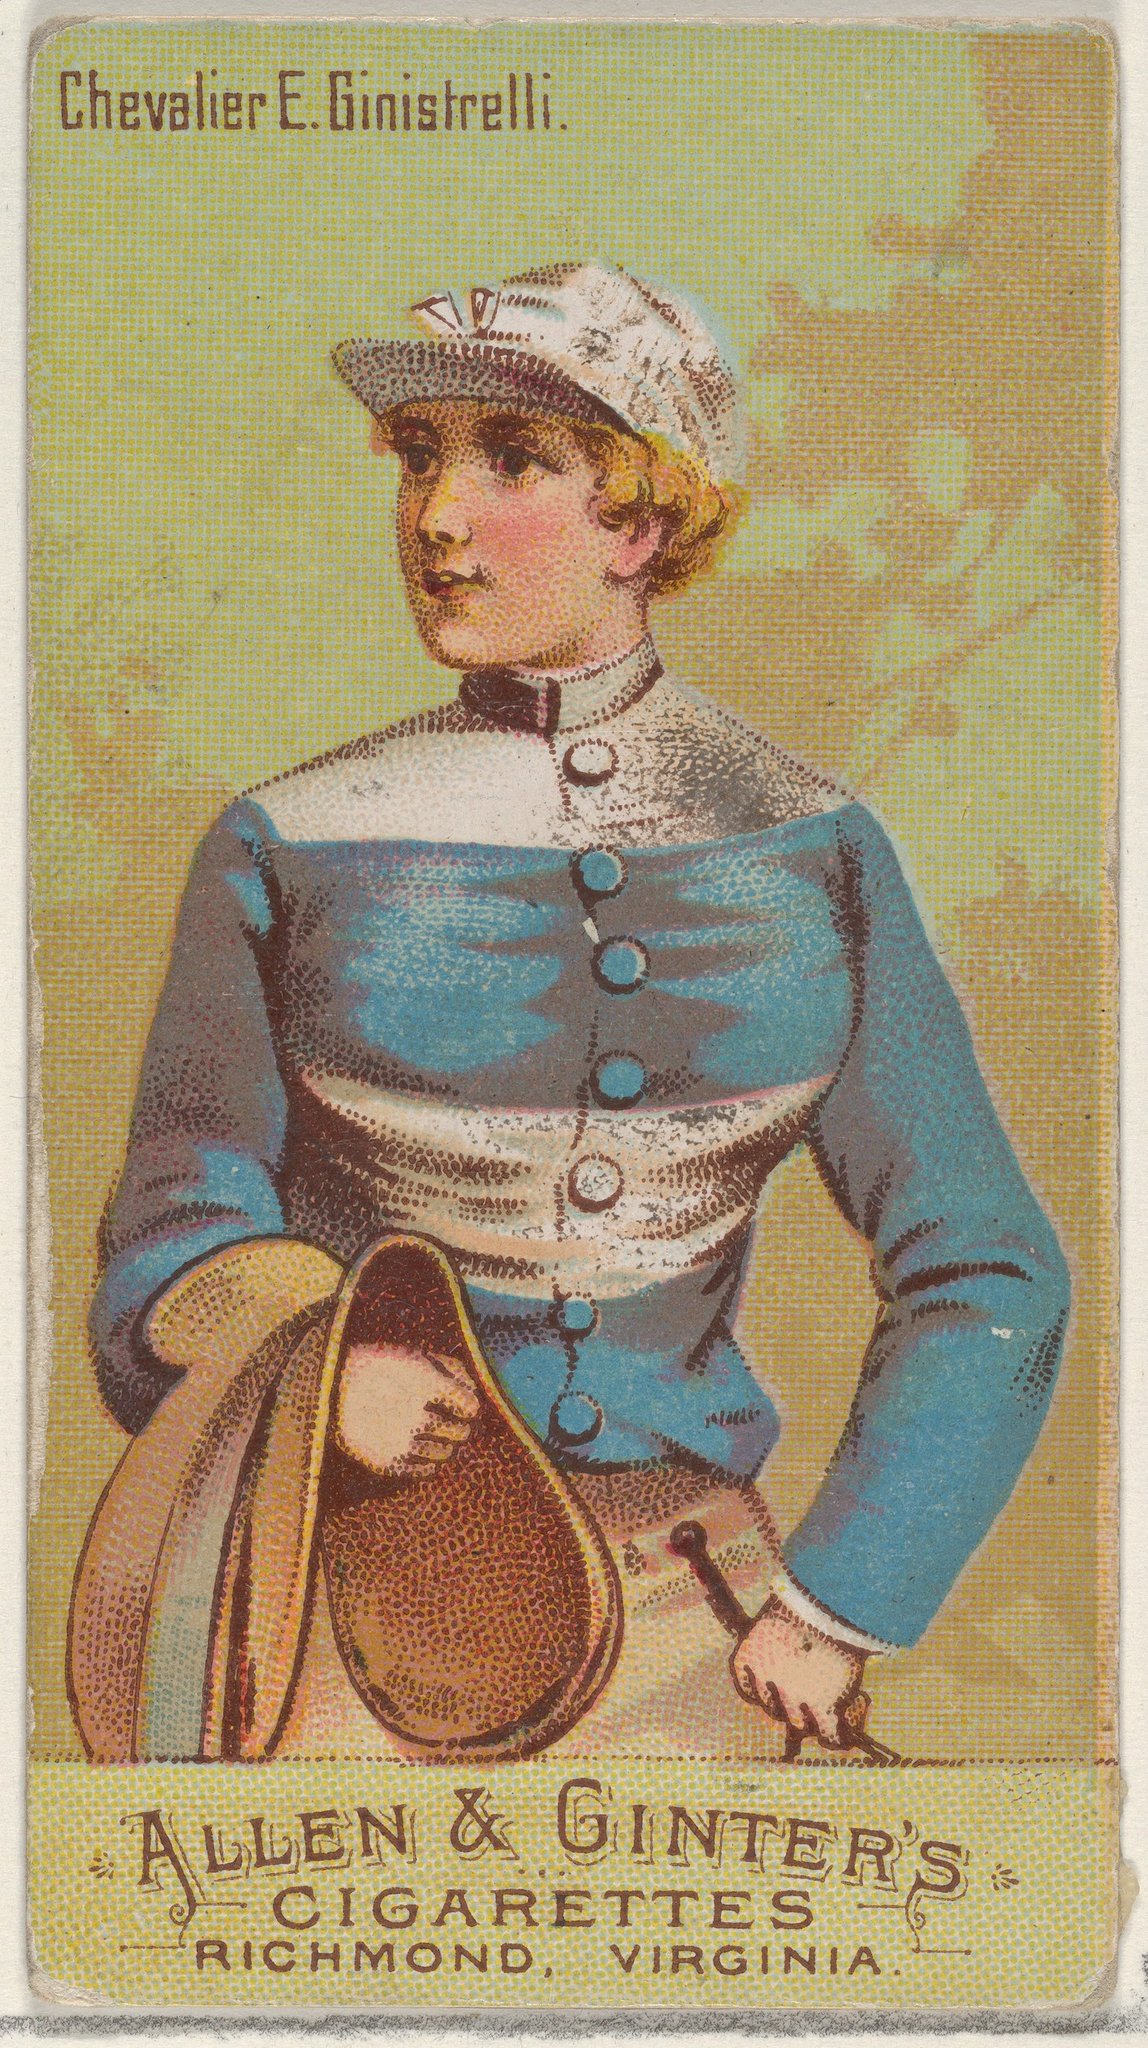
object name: print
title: Chevalier E. Ginistrelli, from the Racing Colors of the World series (N22b) for Allen & Ginter Cigarettes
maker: allen & ginter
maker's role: publisher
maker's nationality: american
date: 1888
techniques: color lithograph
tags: women,jockeys